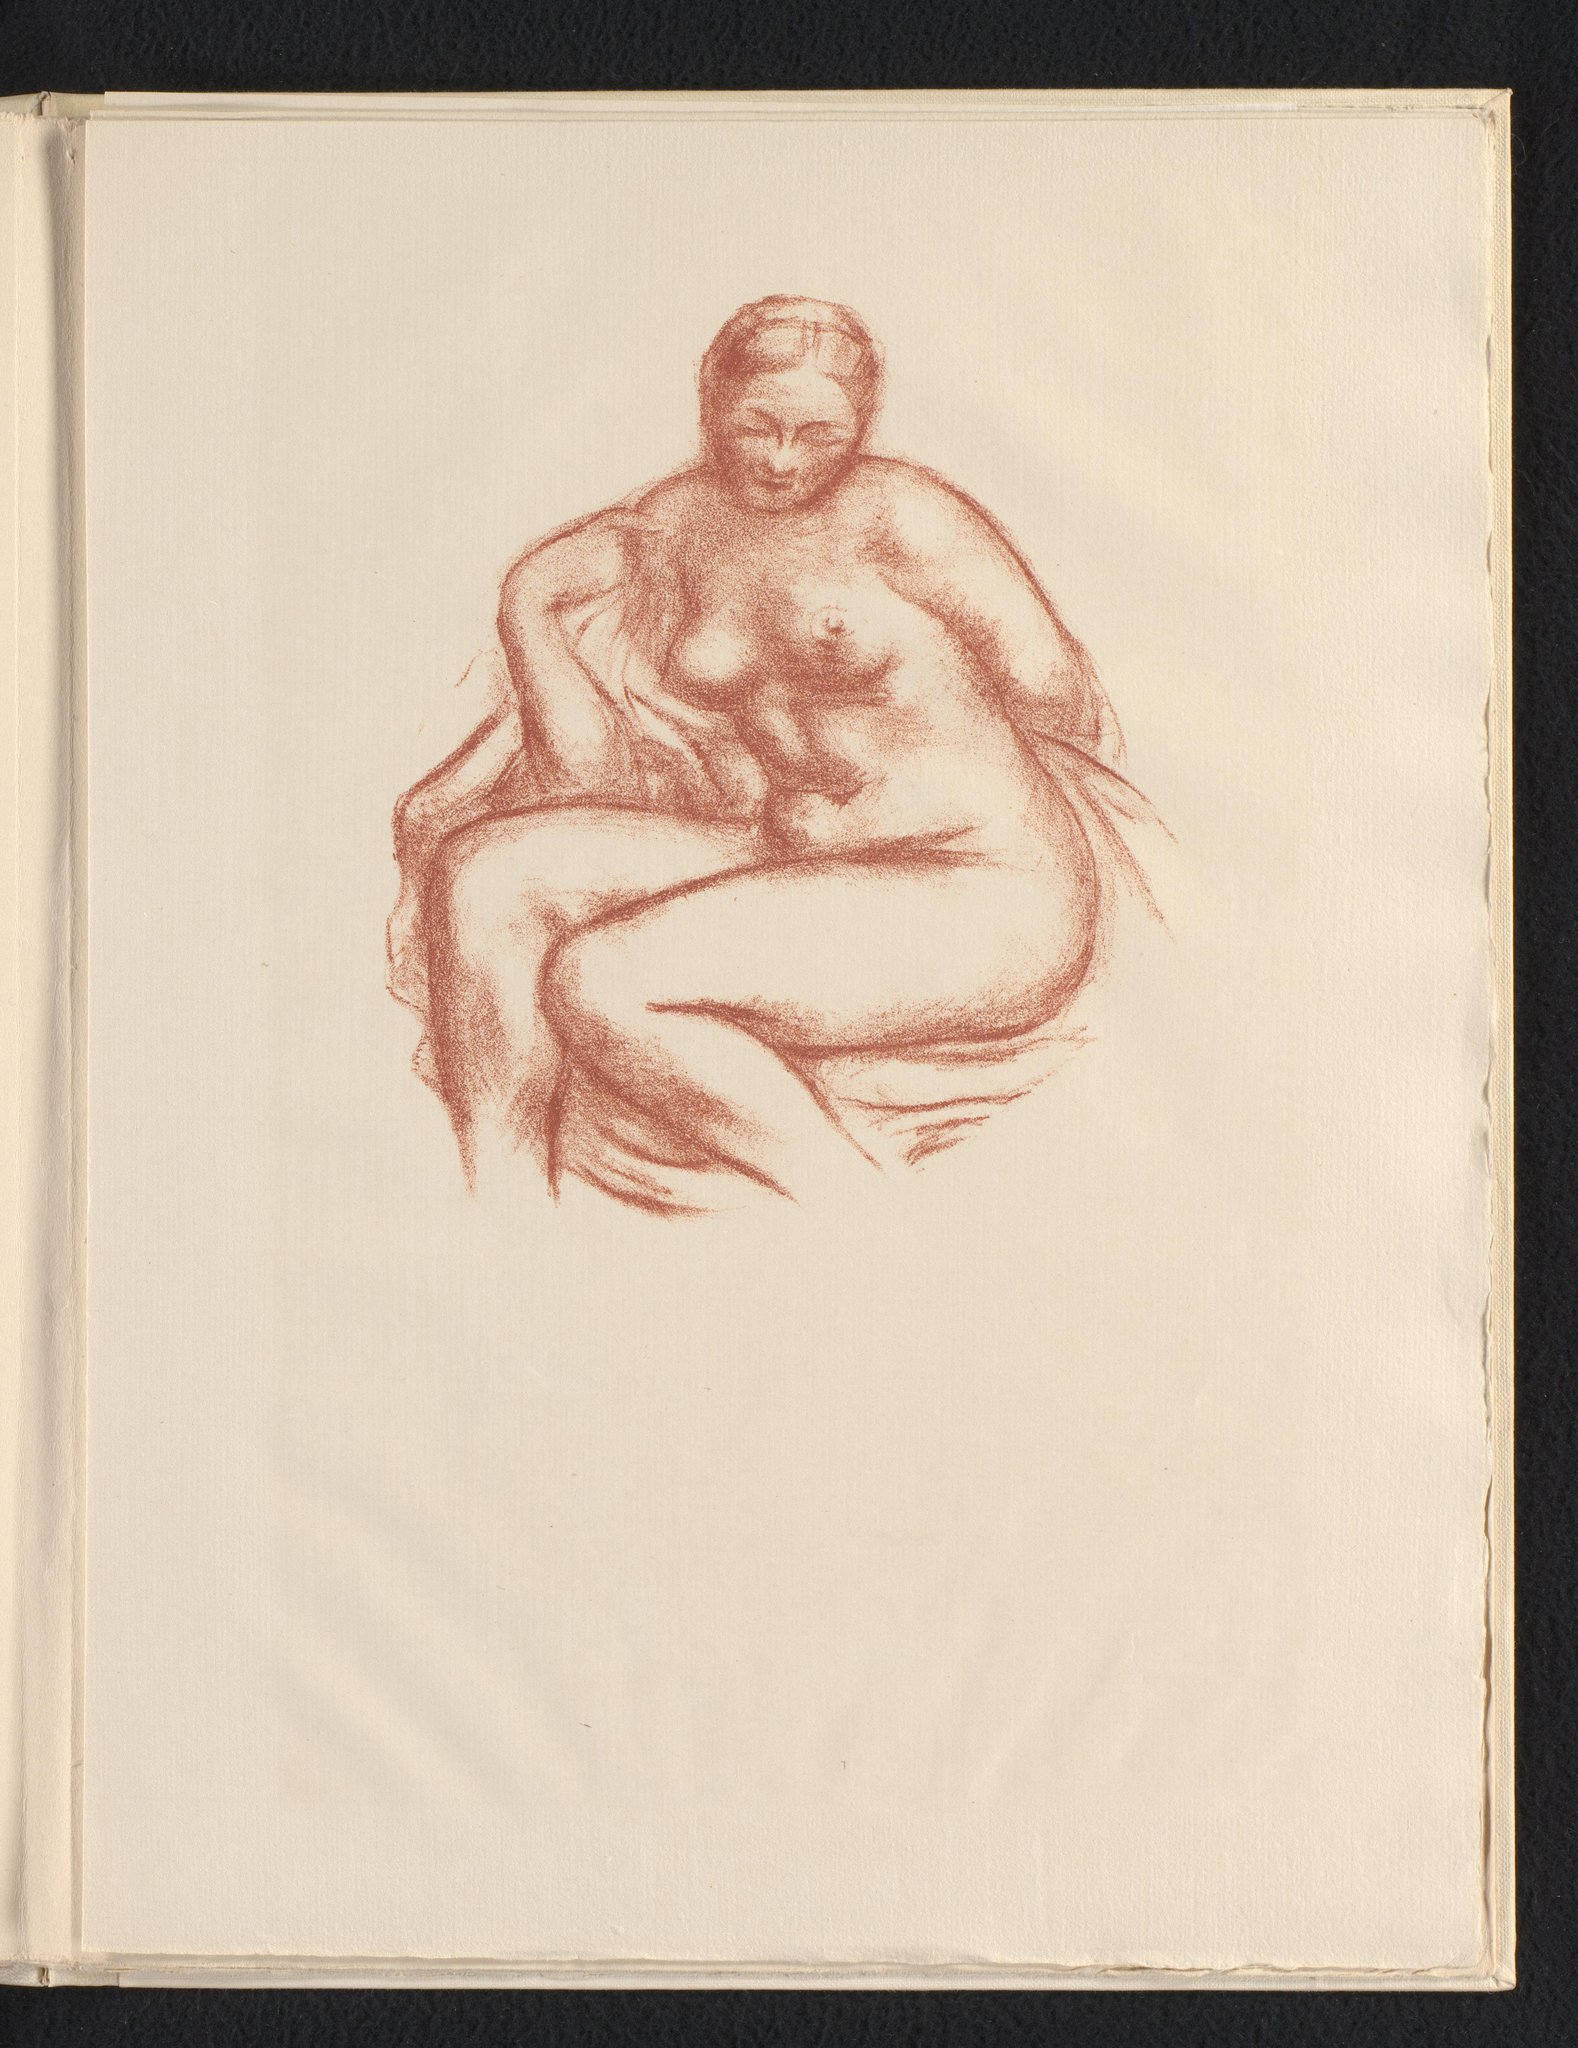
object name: print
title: Zittende naakte vrouw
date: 1948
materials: paper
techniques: lithograph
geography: paris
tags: sitting figure - aa - female human figure, woman (showing herself) undressed, quasi-nude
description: Prent uit: Lucianus van Samosata. Dialogues des Courtisanes. [Vertaald uit het Grieks door] Charles Astruc. Parijs: s.n., 1948, deel van de suite met een extra afdruk van de prenten in sanguine.